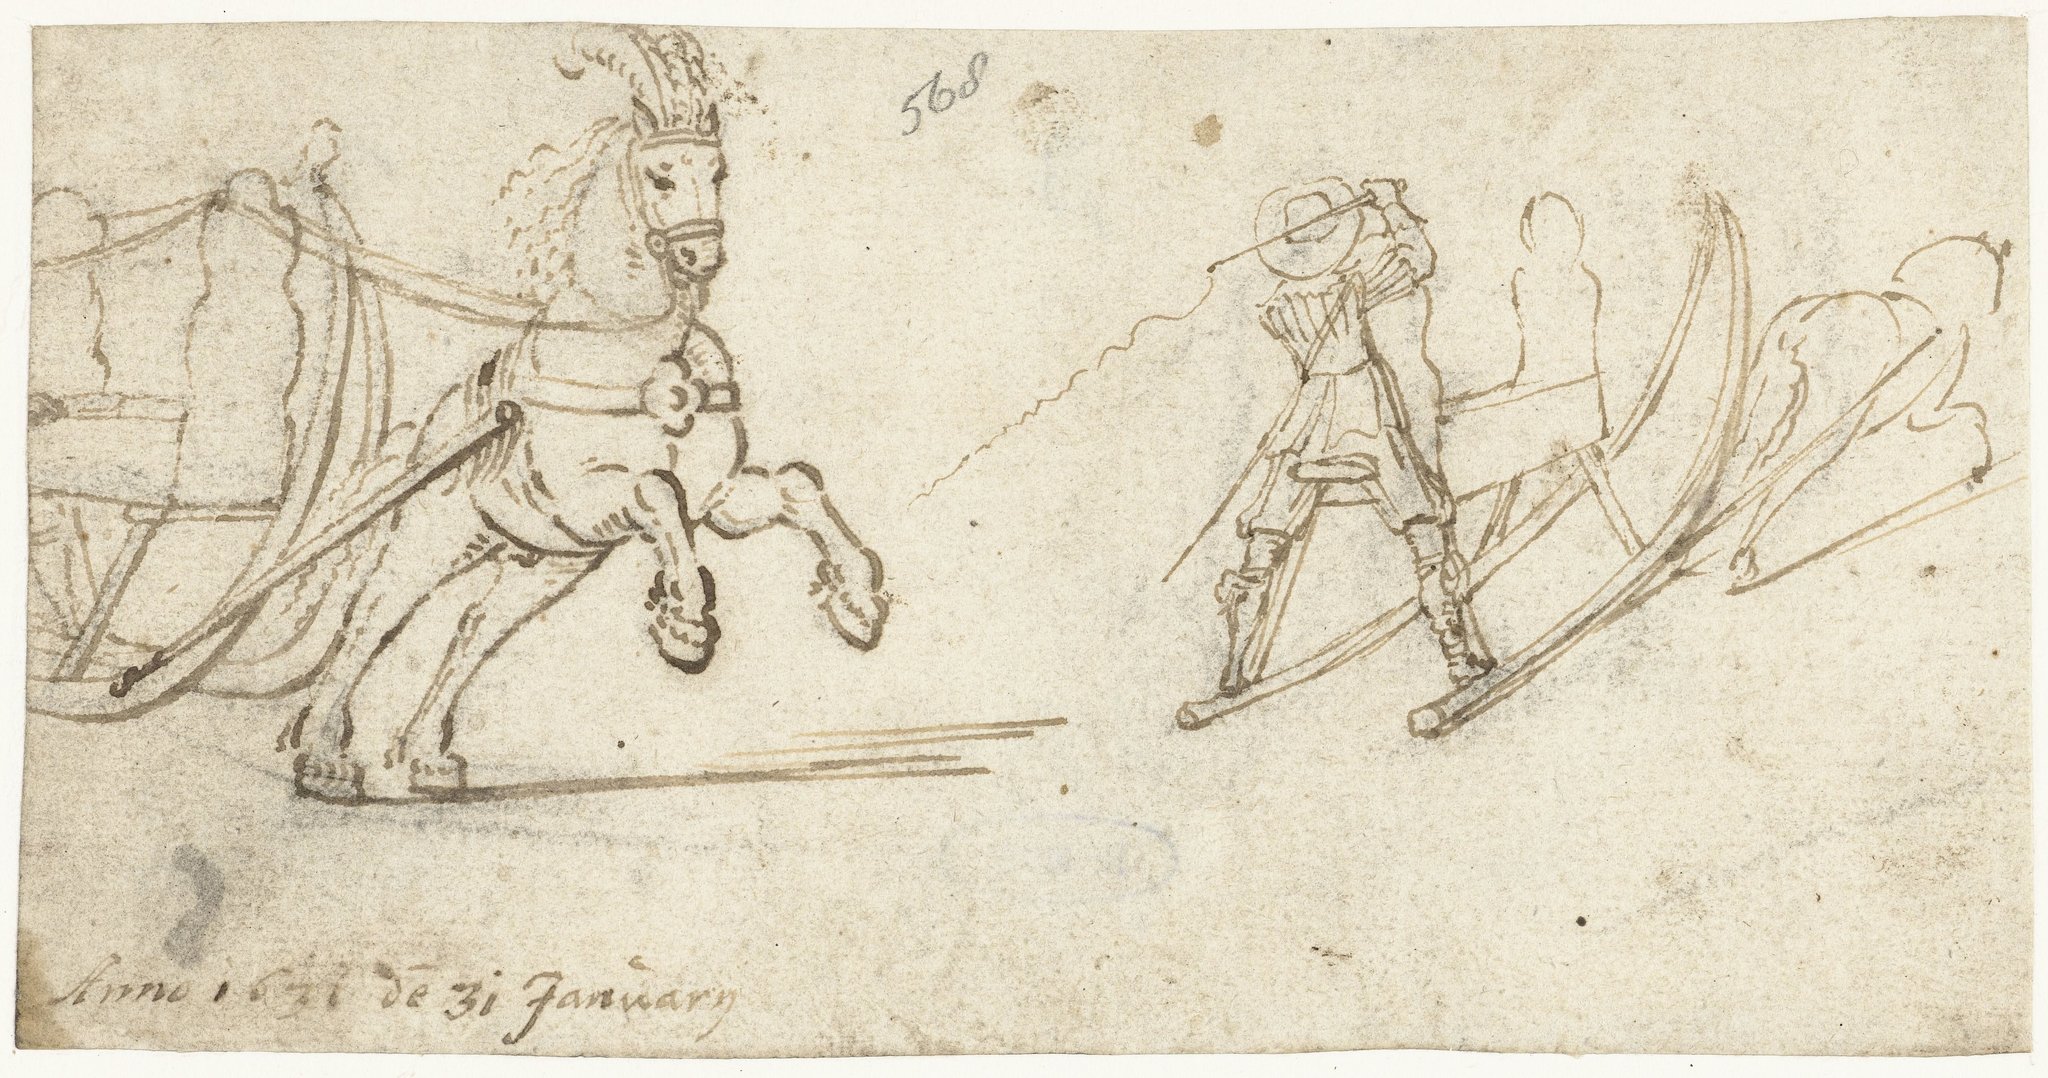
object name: drawing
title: Twee studies van een paard en arrenslee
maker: gerard ter borch (ii)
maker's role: draughtsman, painter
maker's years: 1617-1681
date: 1631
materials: chalk, ink, paper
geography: zwolle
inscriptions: date: ‘Anno 1631. den 31 Januarij’